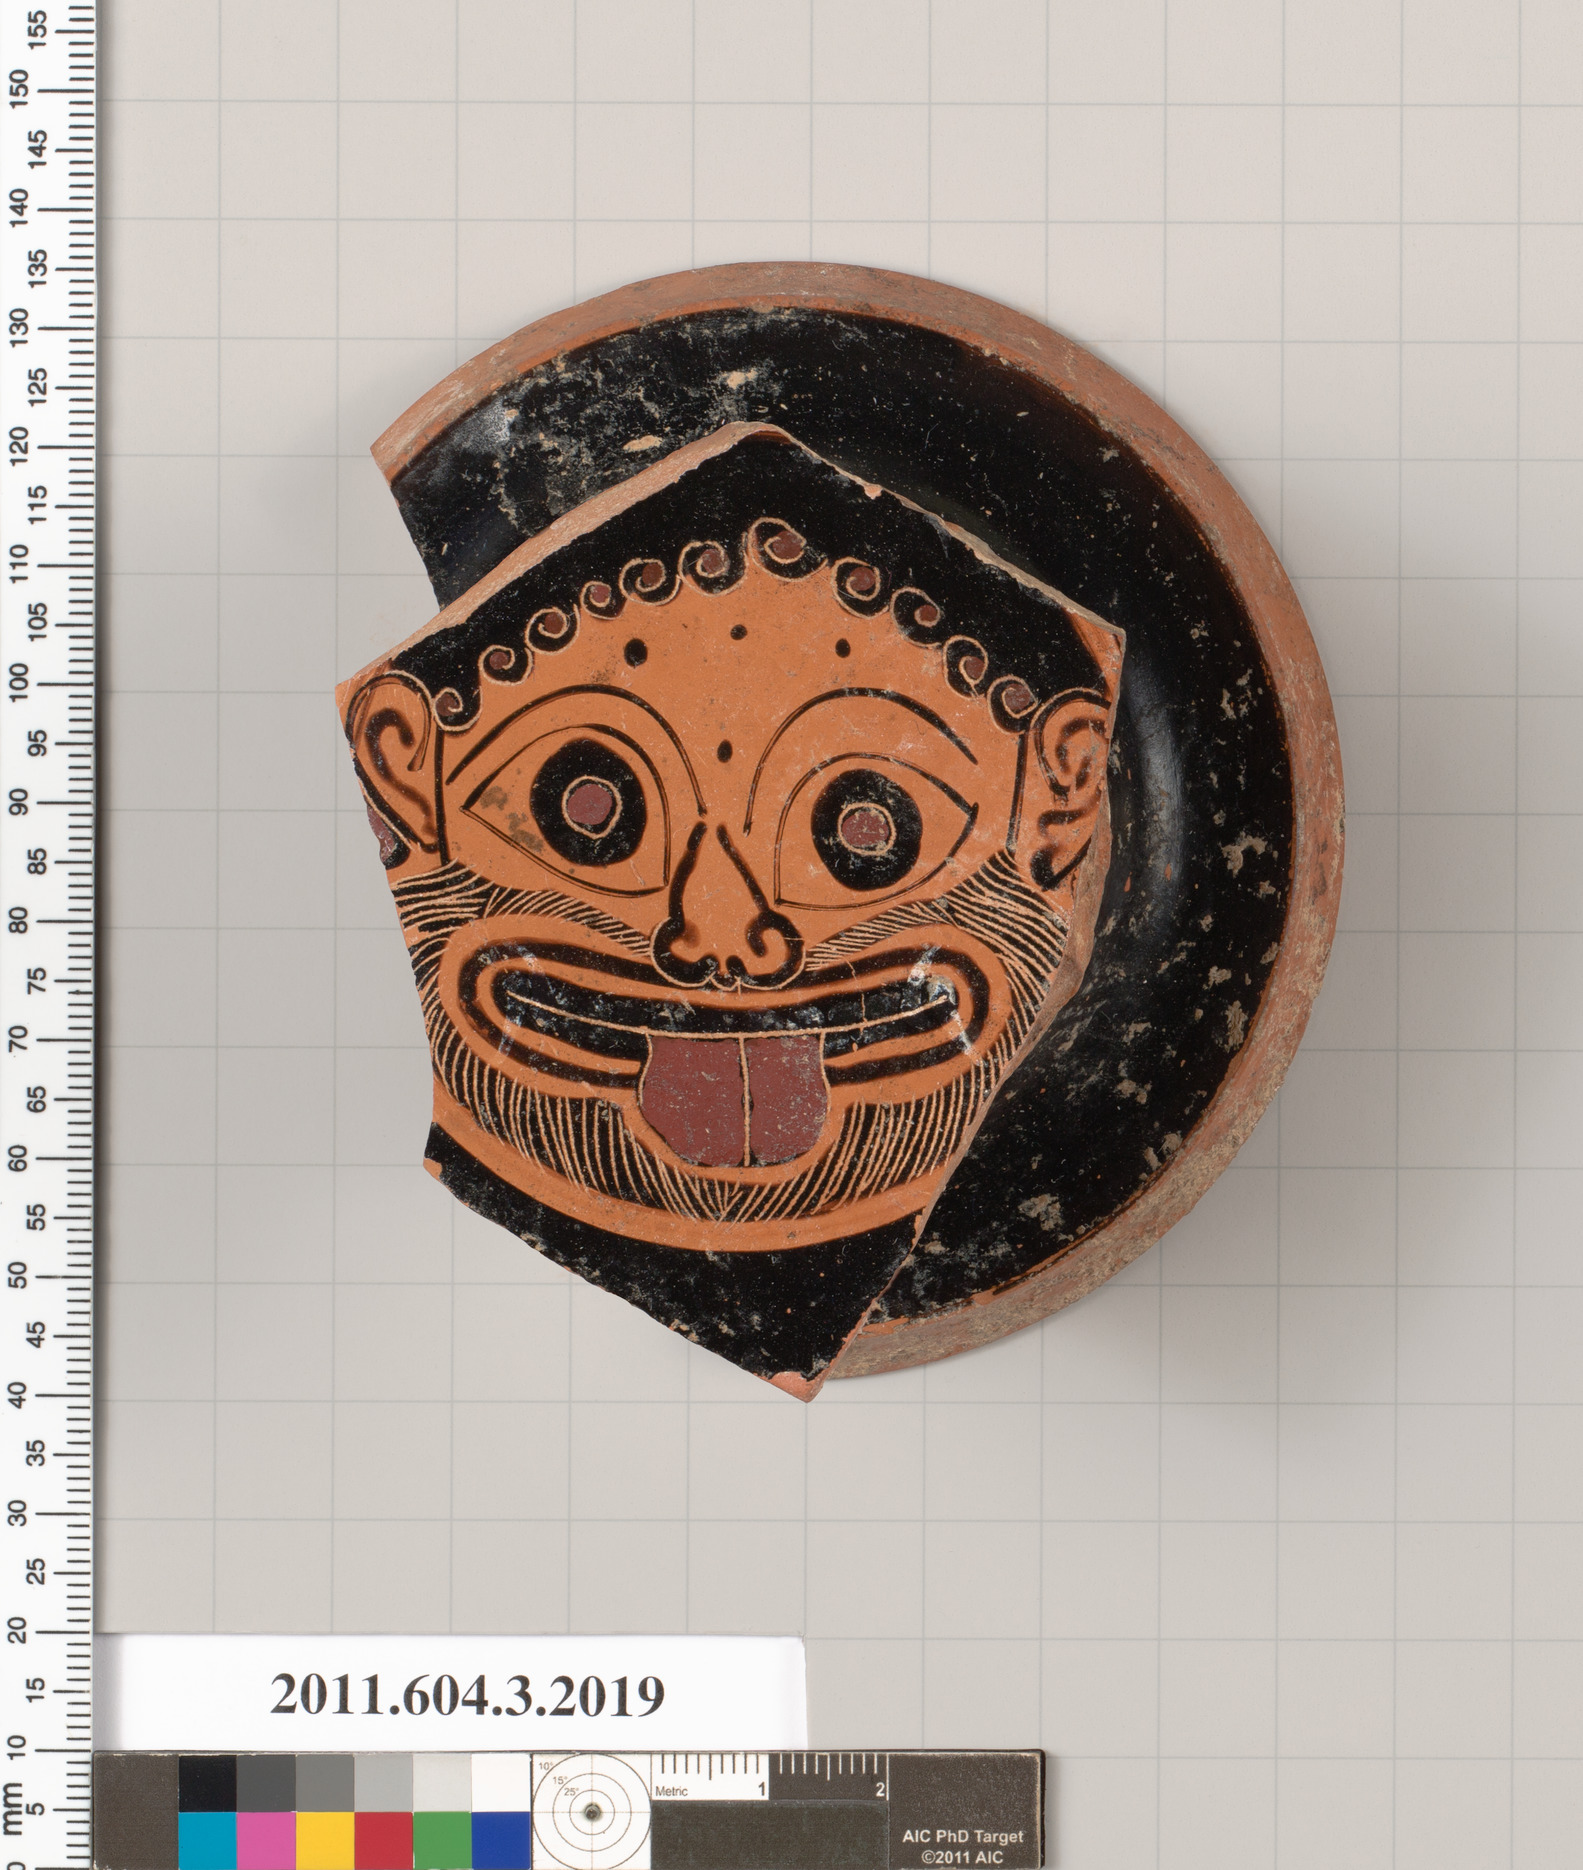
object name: kylix fragment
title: Terracotta fragment of a kylix (drinking cup)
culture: greek, attic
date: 540-530 BCE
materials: terracotta